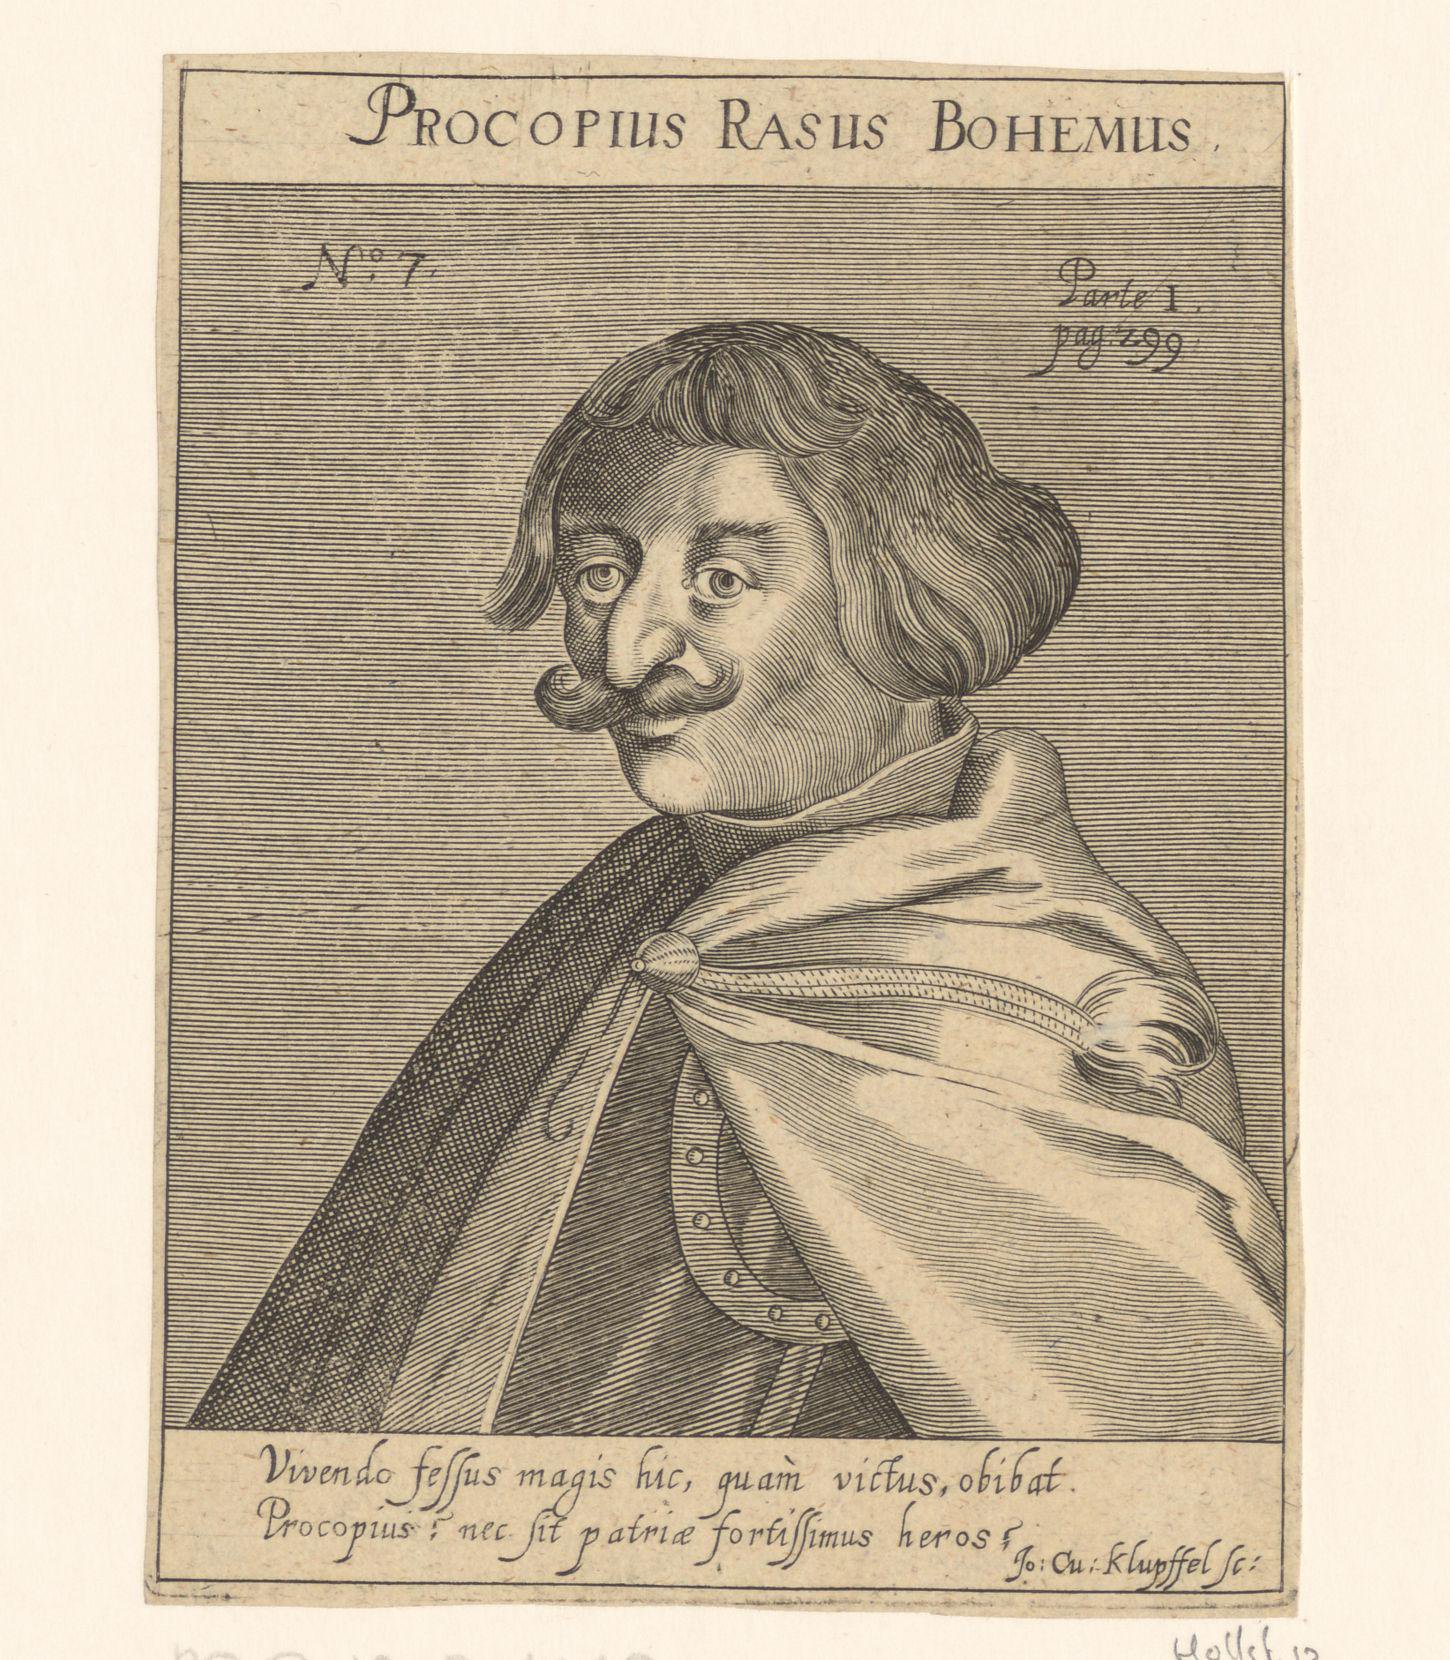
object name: print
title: Portret van Prokop de Grote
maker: johann conrad klüpfel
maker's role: print maker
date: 1621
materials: paper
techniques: engraving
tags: commander-in-chief, general, marshal, historical persons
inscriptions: collector's mark: Lugt 2228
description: Dit is een van de veertien prenten door Johann Conrad Klüpfel, gebruikt in: Theobald, Zacharias. Bellum hussiticum. Frankfurt: s.n., 1621.